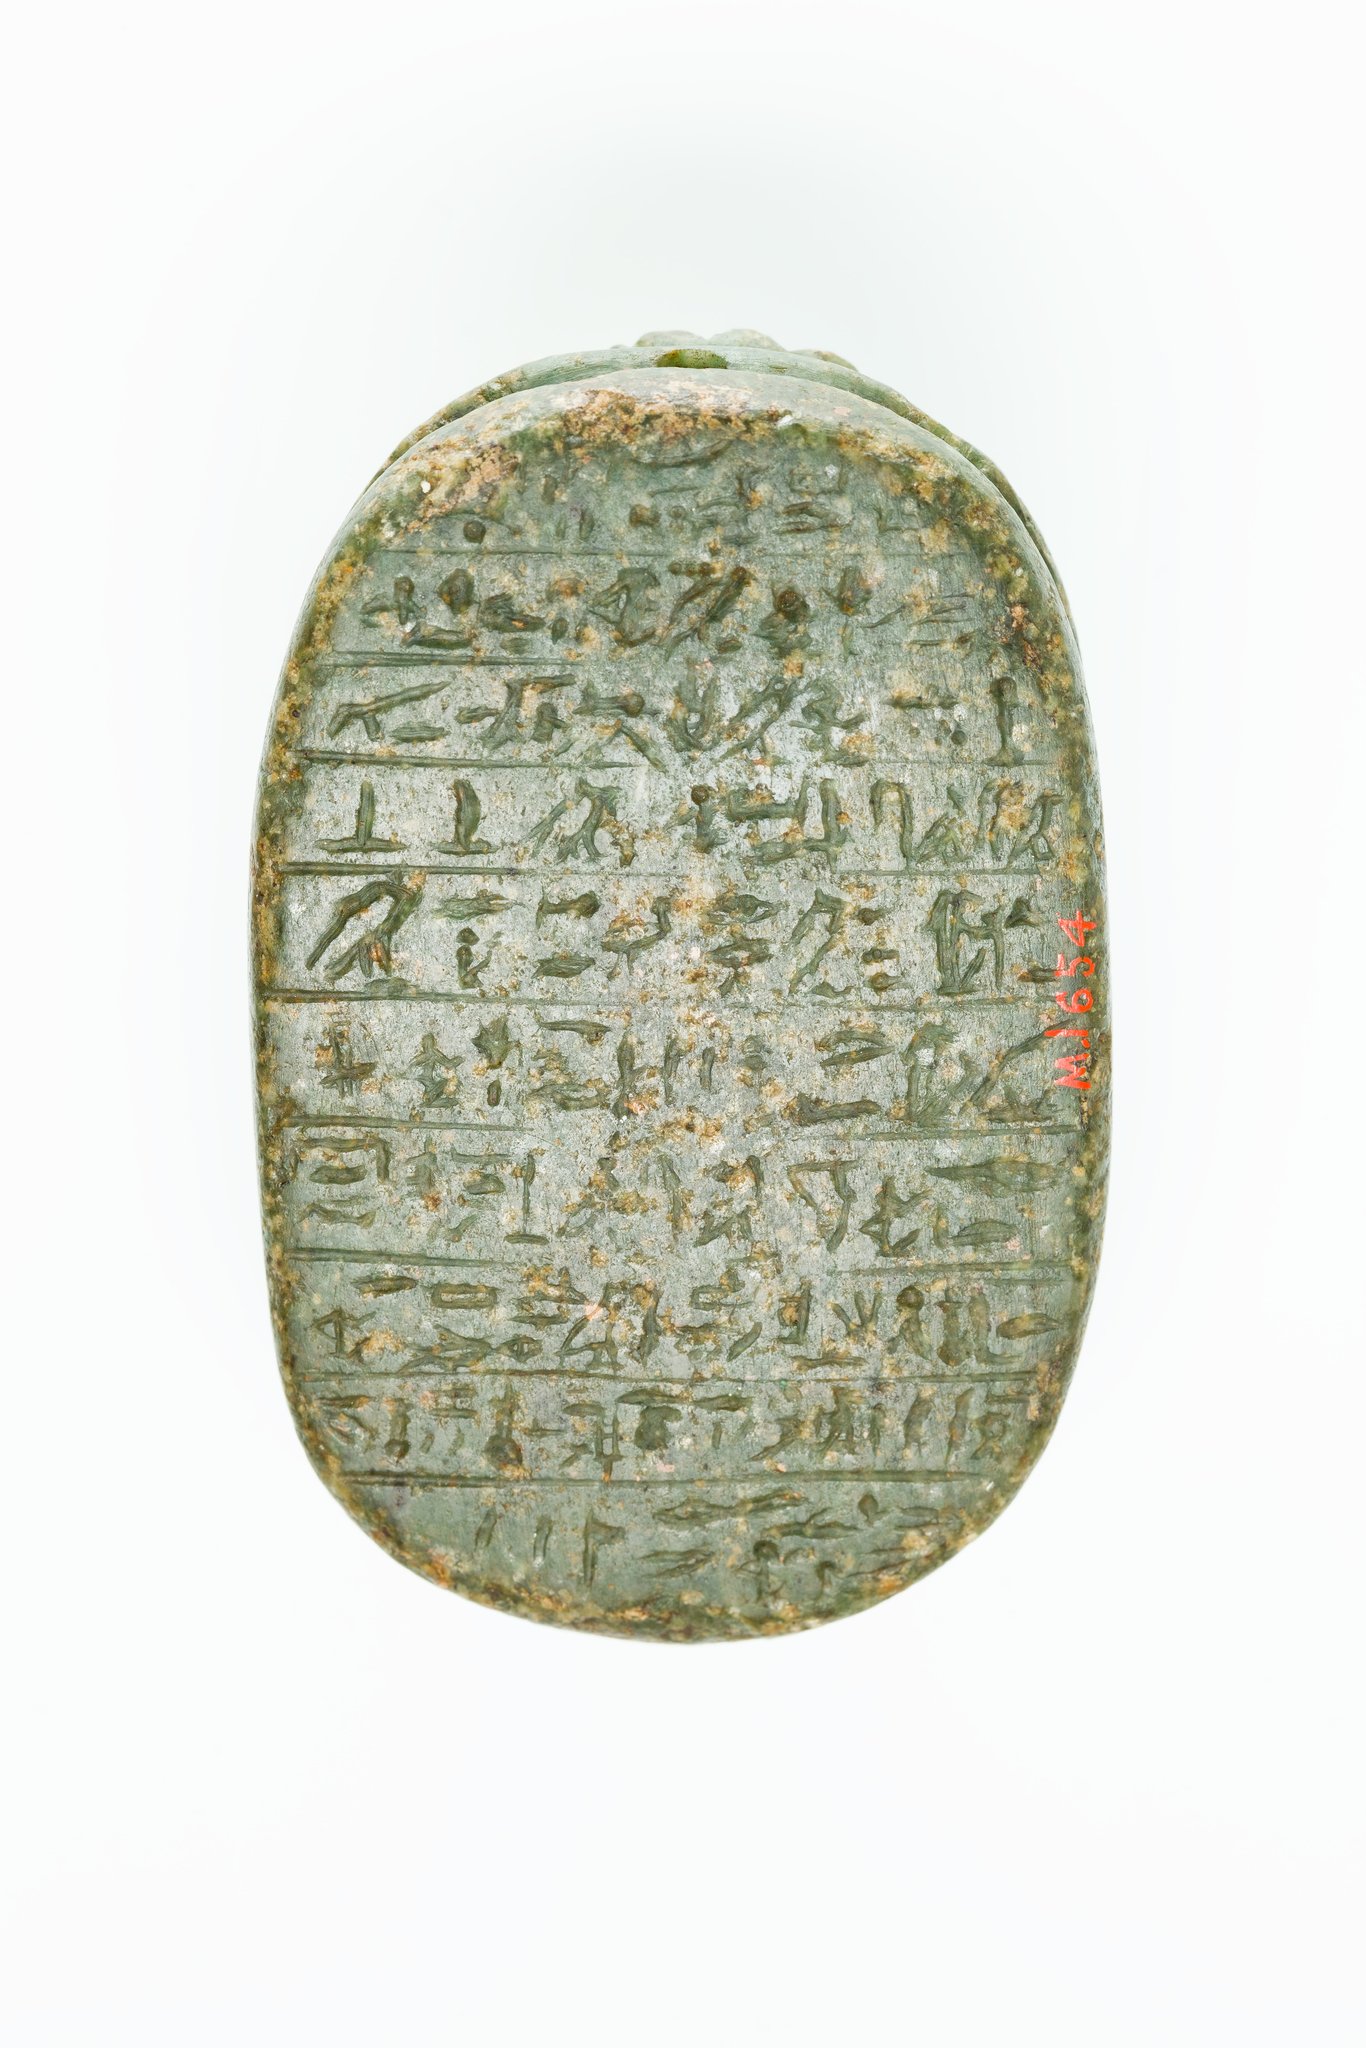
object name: heart scarab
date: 1295-1070 BCE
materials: stone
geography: egypt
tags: scarabs